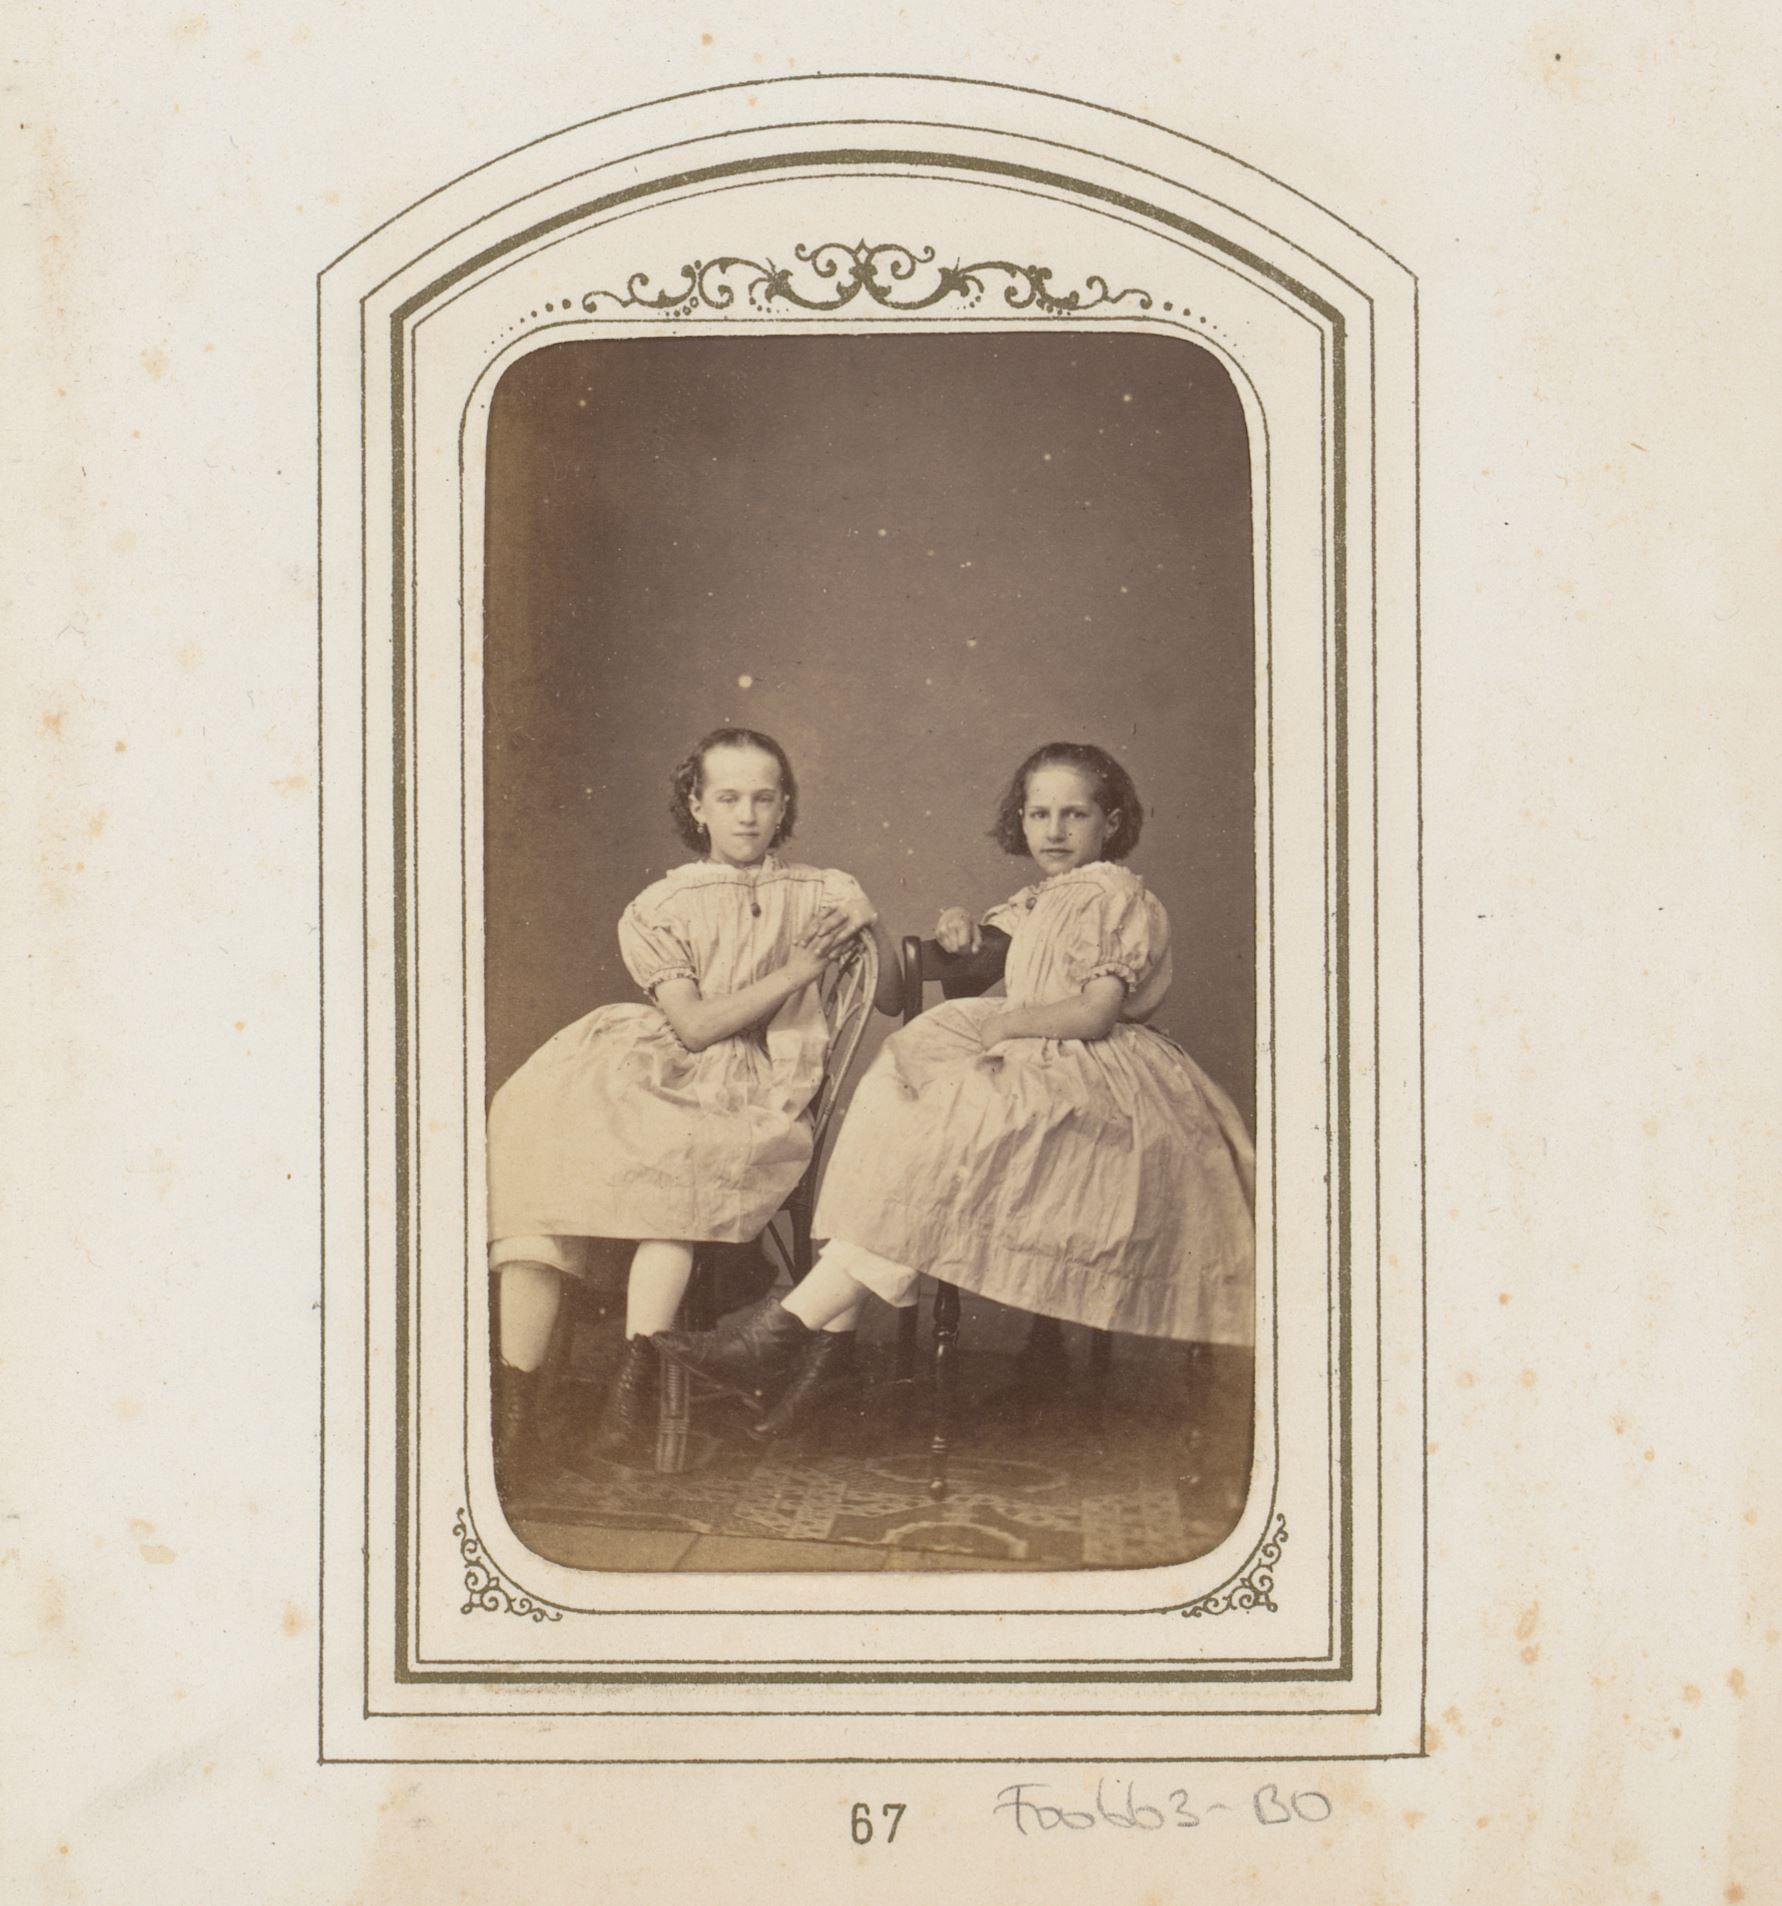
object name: carte de visite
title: Portret van twee zittende meisjes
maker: roelof loots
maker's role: fotograaf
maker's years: 1814-1898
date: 1860-1880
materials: cardboard, photographic support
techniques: albumen print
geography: medemblik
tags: girl (child between toddler and youth)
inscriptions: inscription: ‘Photographie van R. Loots/ Medemblik’, number: ‘67’